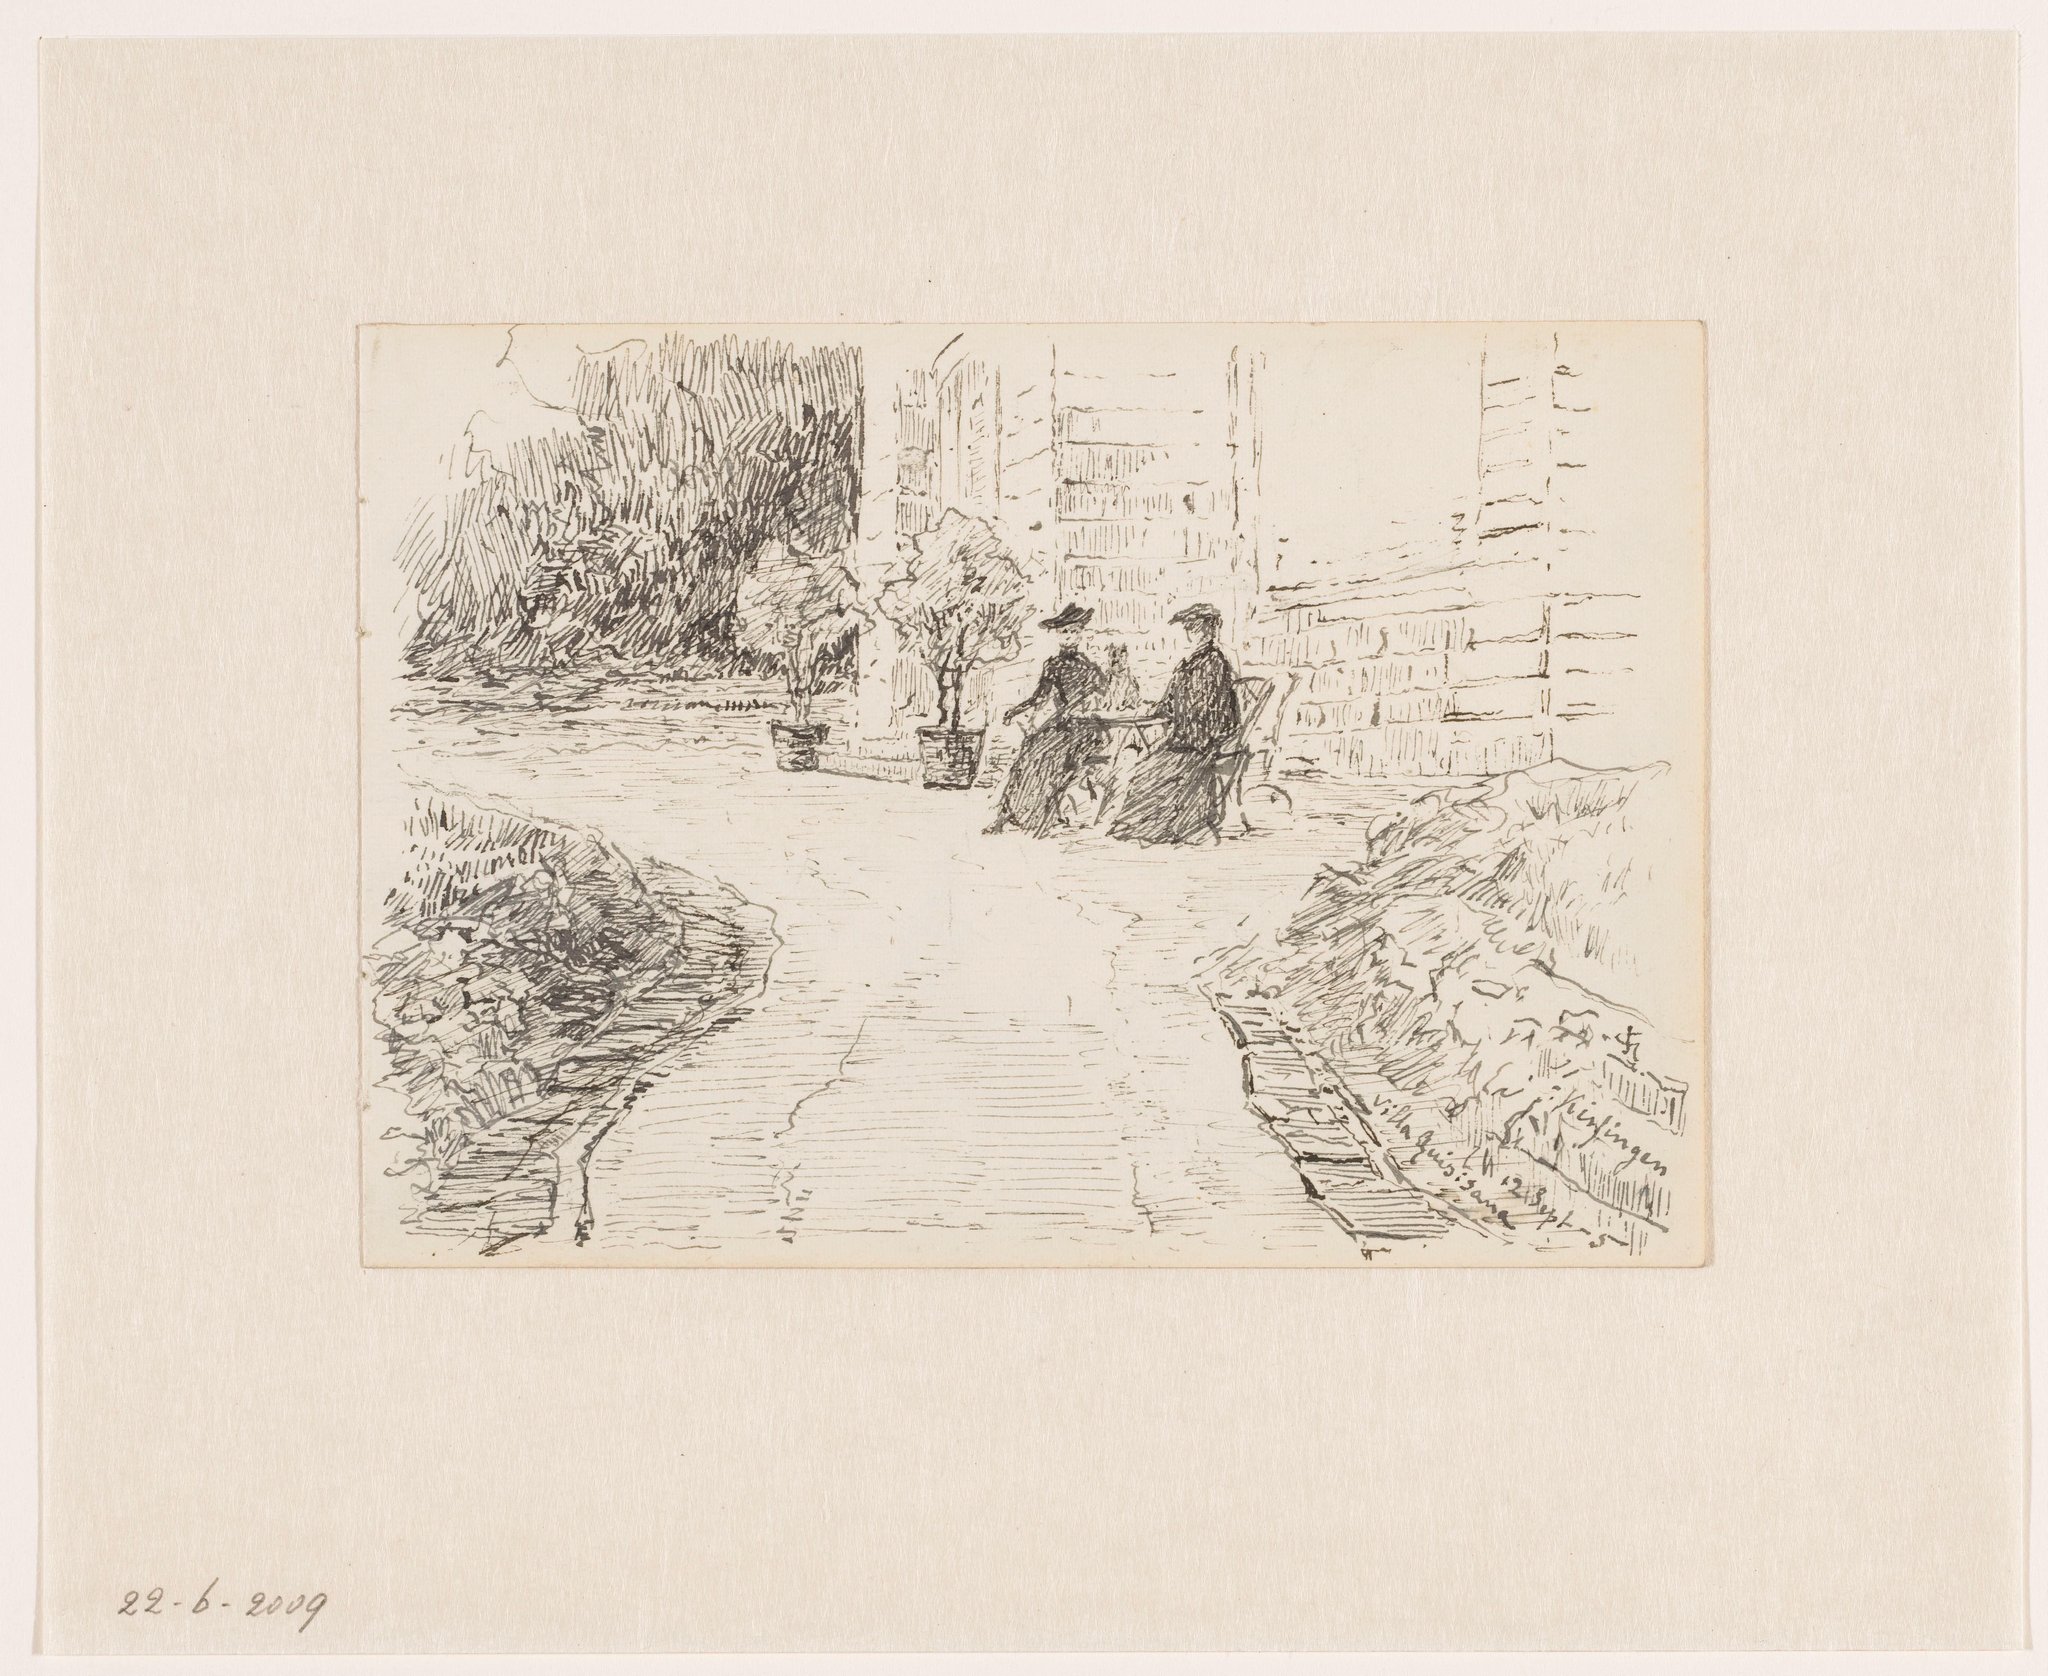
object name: drawing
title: Twee dames zittend in de tuin voor de villa Quisisana te Vlissingen (?)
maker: carel nicolaas storm van s-gravesande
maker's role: draughtsman, print maker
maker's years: 1841-1924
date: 1905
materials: ink, paper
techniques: pen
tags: flushing